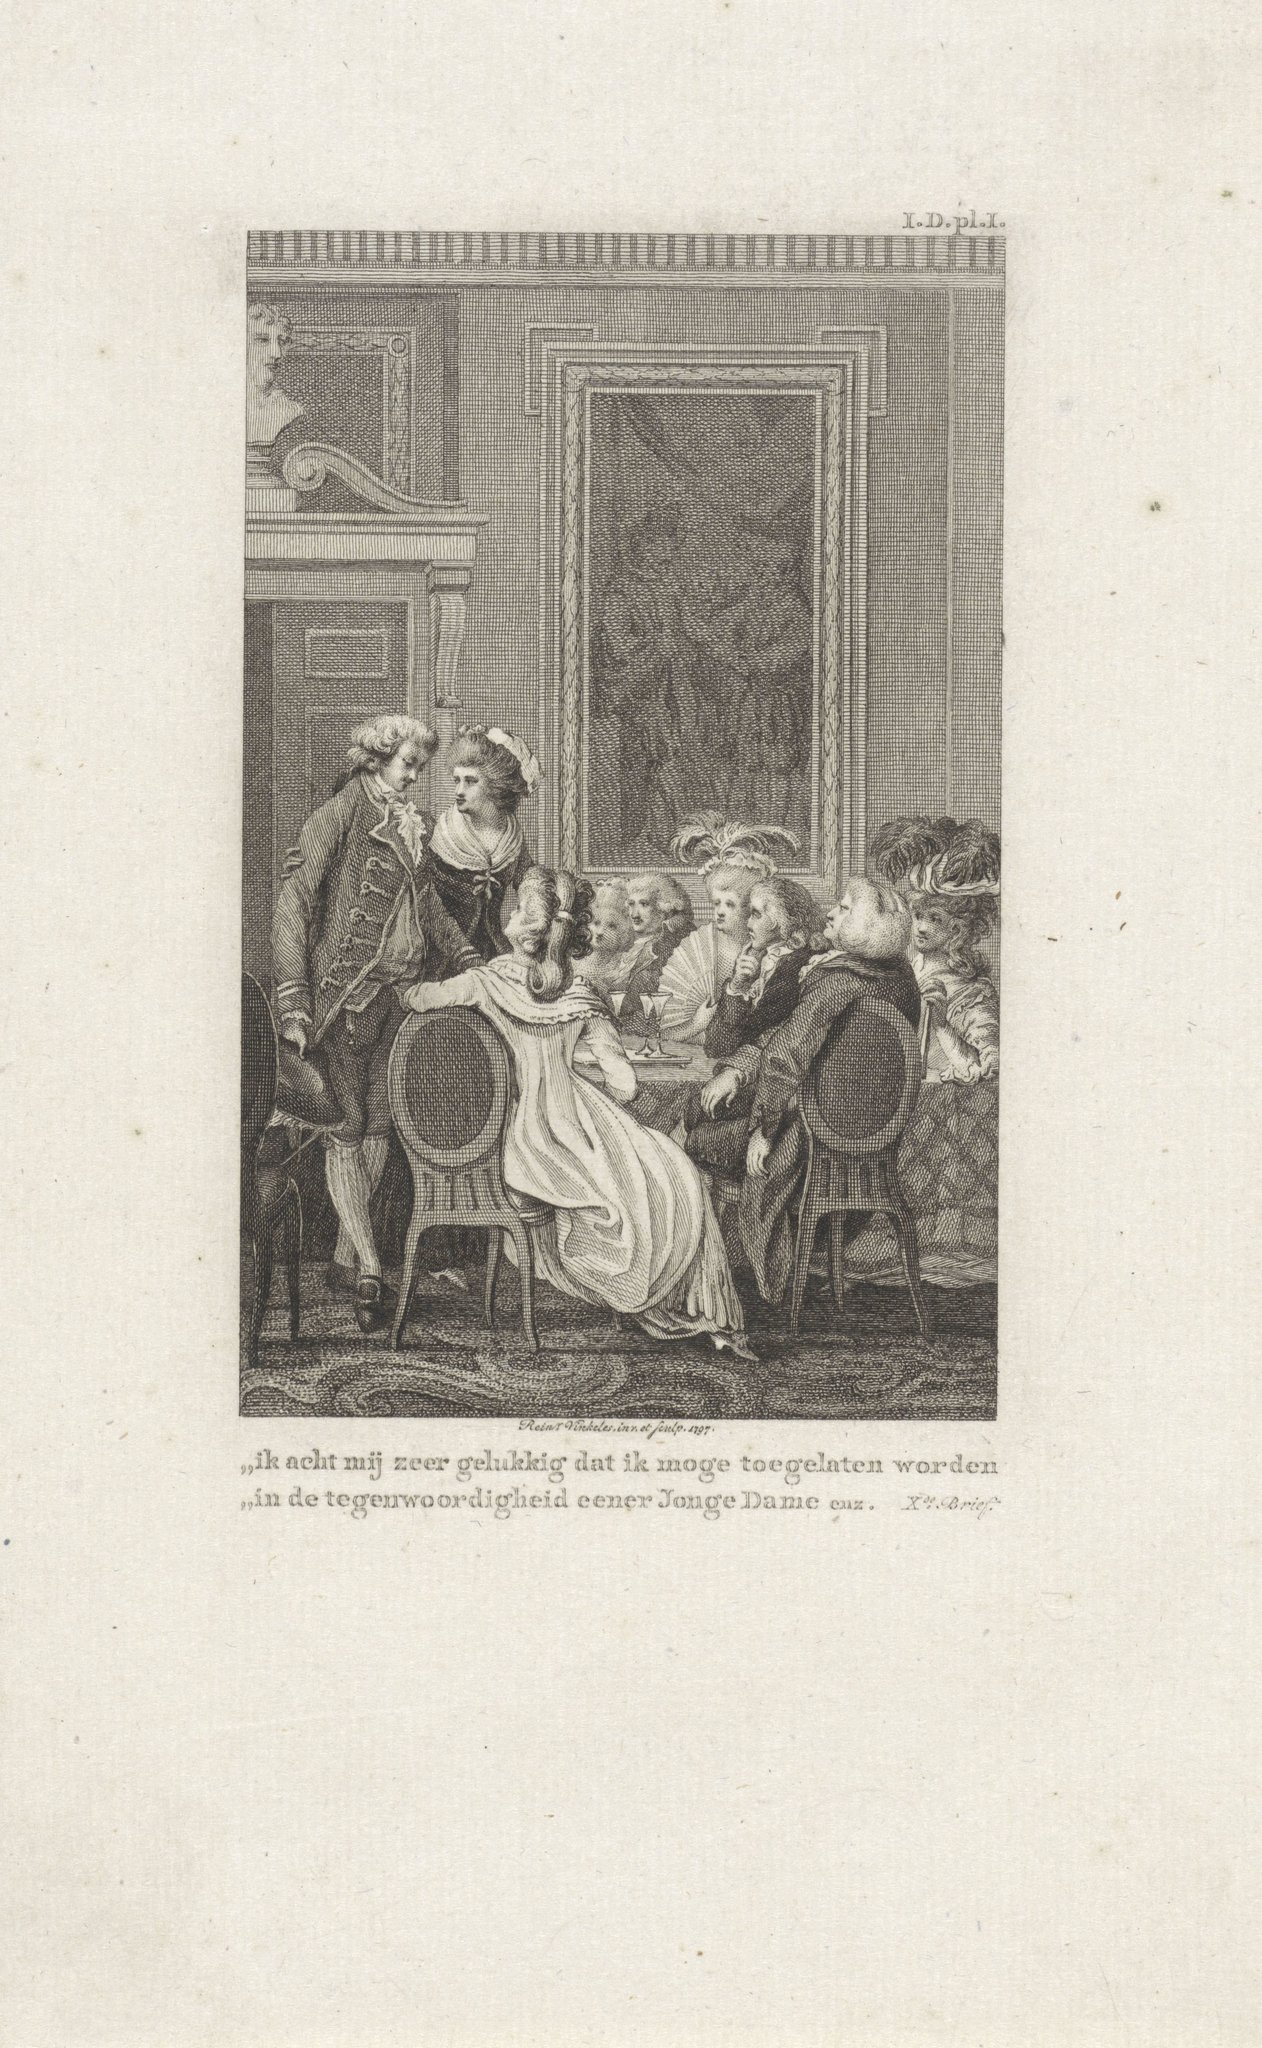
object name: print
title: Jonge heer wordt voorgesteld aan een jonge dame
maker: reinier vinkeles (i)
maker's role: draughtsman, print maker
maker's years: 1741-1816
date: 1797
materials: paper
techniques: engraving, etching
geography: amsterdam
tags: introducing, evening meal, dinner, supper, picture, painting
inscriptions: collector's mark: Lugt 240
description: Illustratie uit: Richardson, Samuel. Geschiedenis van Karel Grandison. Amsterdam: Johannes Allart, 1797-1802.